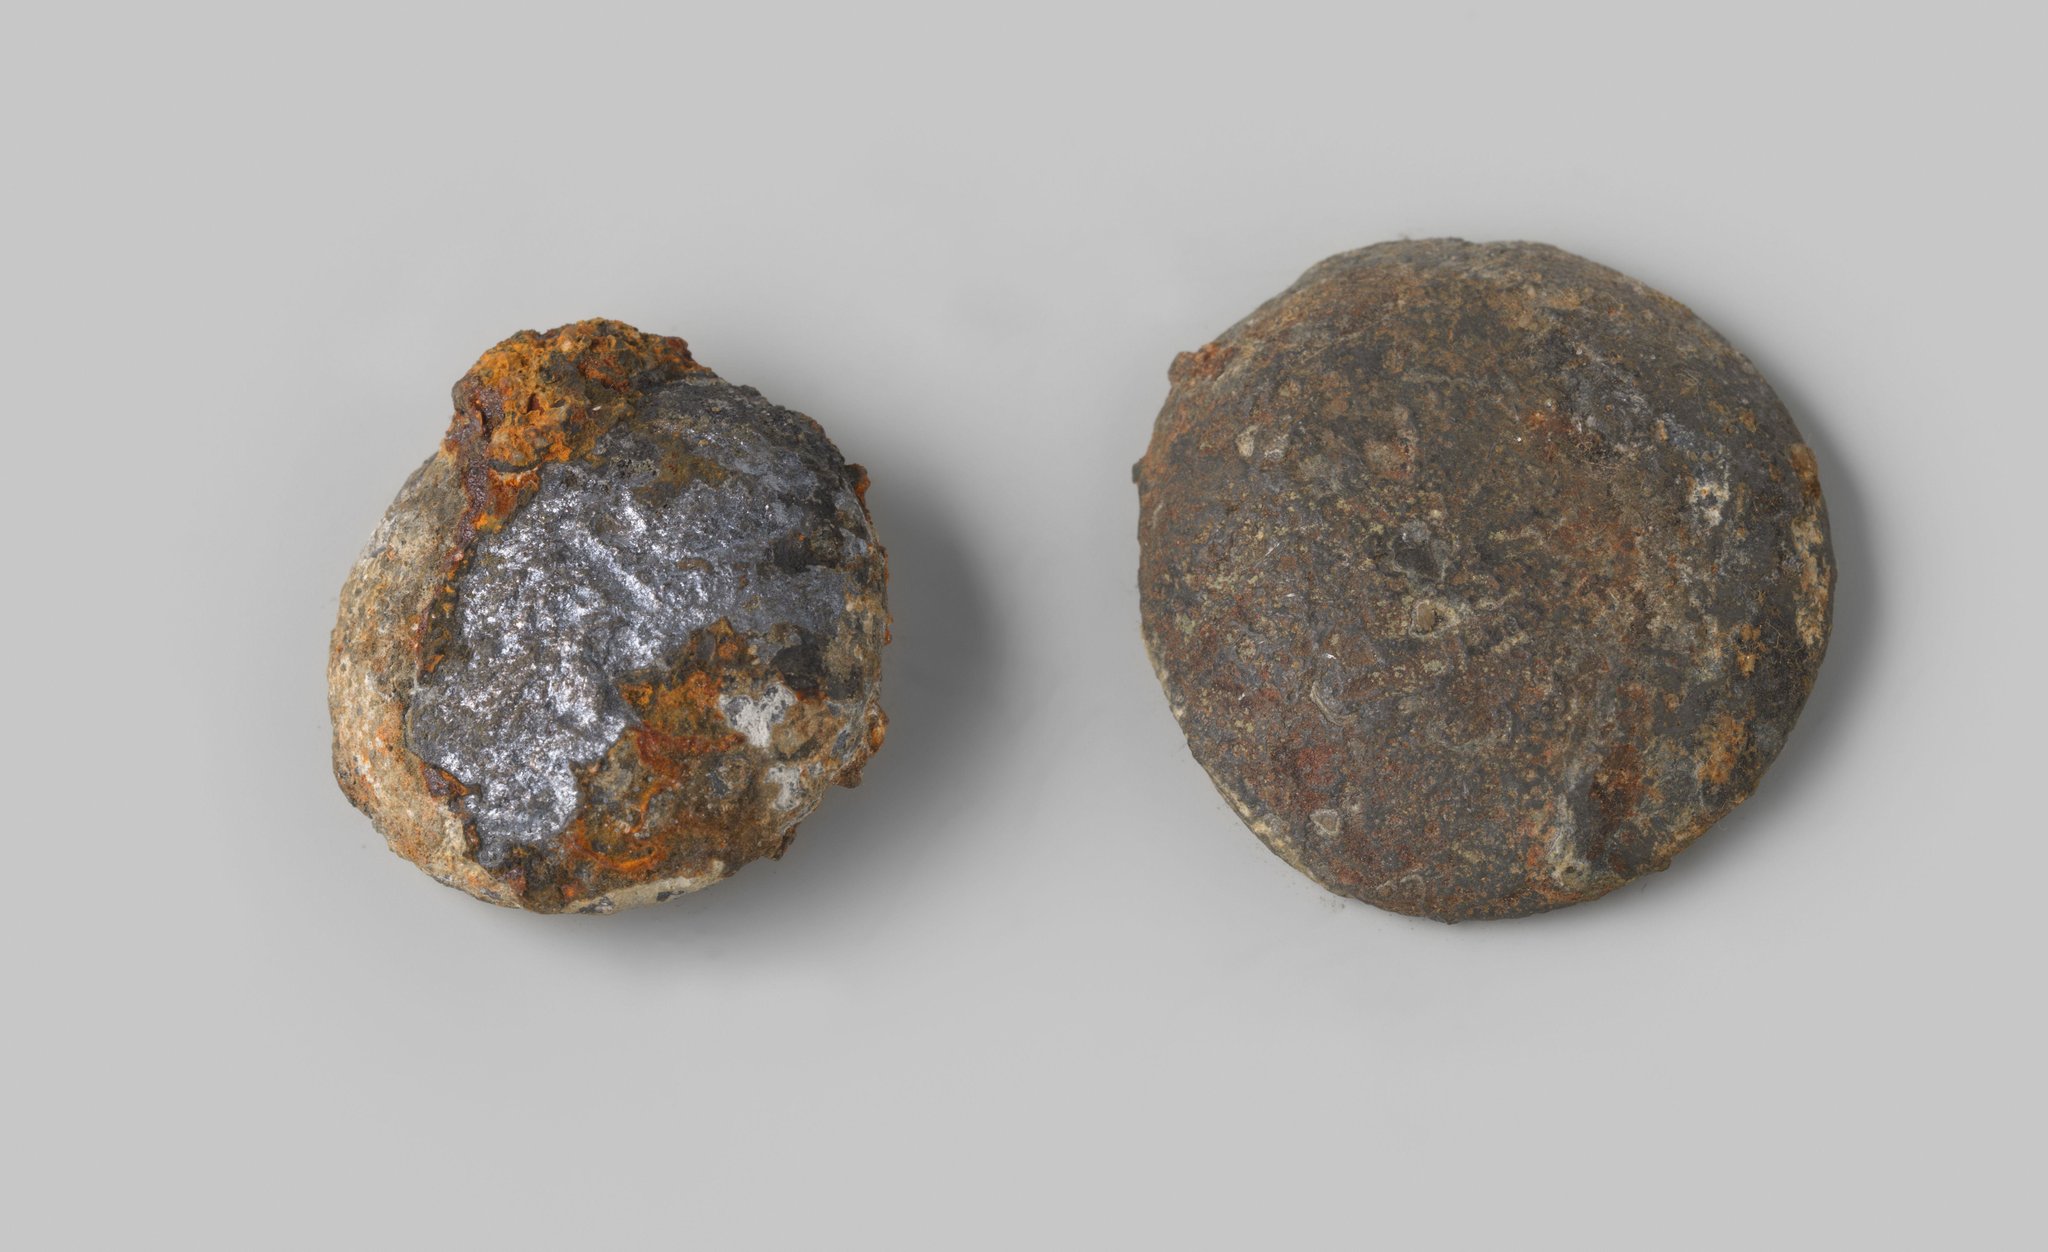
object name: weight scale component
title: Gewichten uit het wrak van de Oost-Indiëvaarder Hollandia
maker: Anonymous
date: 1700-1743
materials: lead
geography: netherlands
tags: verenigde oostindische compagnie, hollandia (schip), annet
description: Disc-shaped weight, sim. NG 1979-344H, concreted; sim. NG 1980-27H2928, eroded.